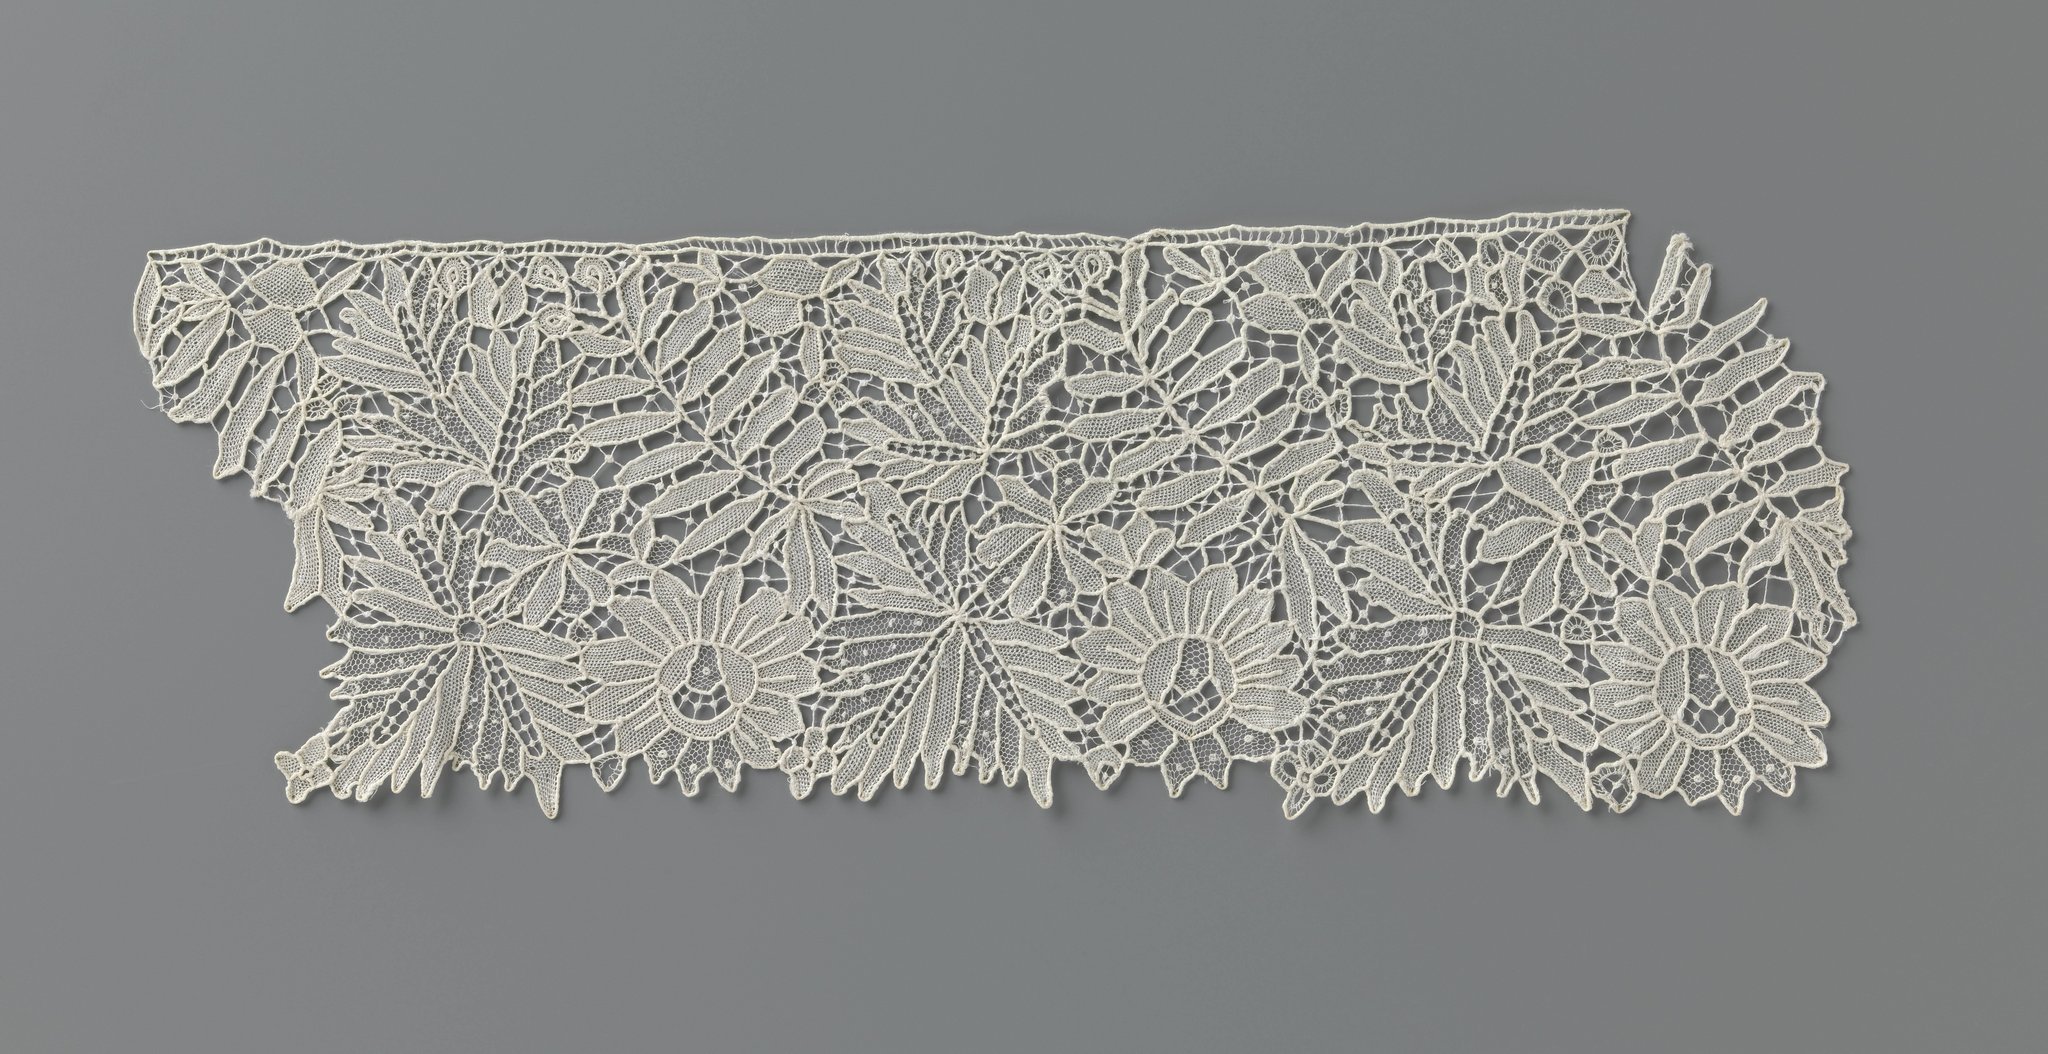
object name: strip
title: Strook naaldkant met ingesneden blad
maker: Anonymous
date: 1900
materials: linen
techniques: needle lace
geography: karlsbad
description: Lopend patroon van ingesneden bladeren boven een roos en een drieblad, die samen de scherp getande buitenlijn vormen. Kruisvormige spijlen met knoopje (grond van lange X-vormige spijlen met een spin). Het remplis bestaat uit knoopsgatensteken en een fond gazé. Duitse kant: 'Carlsbader Points'.